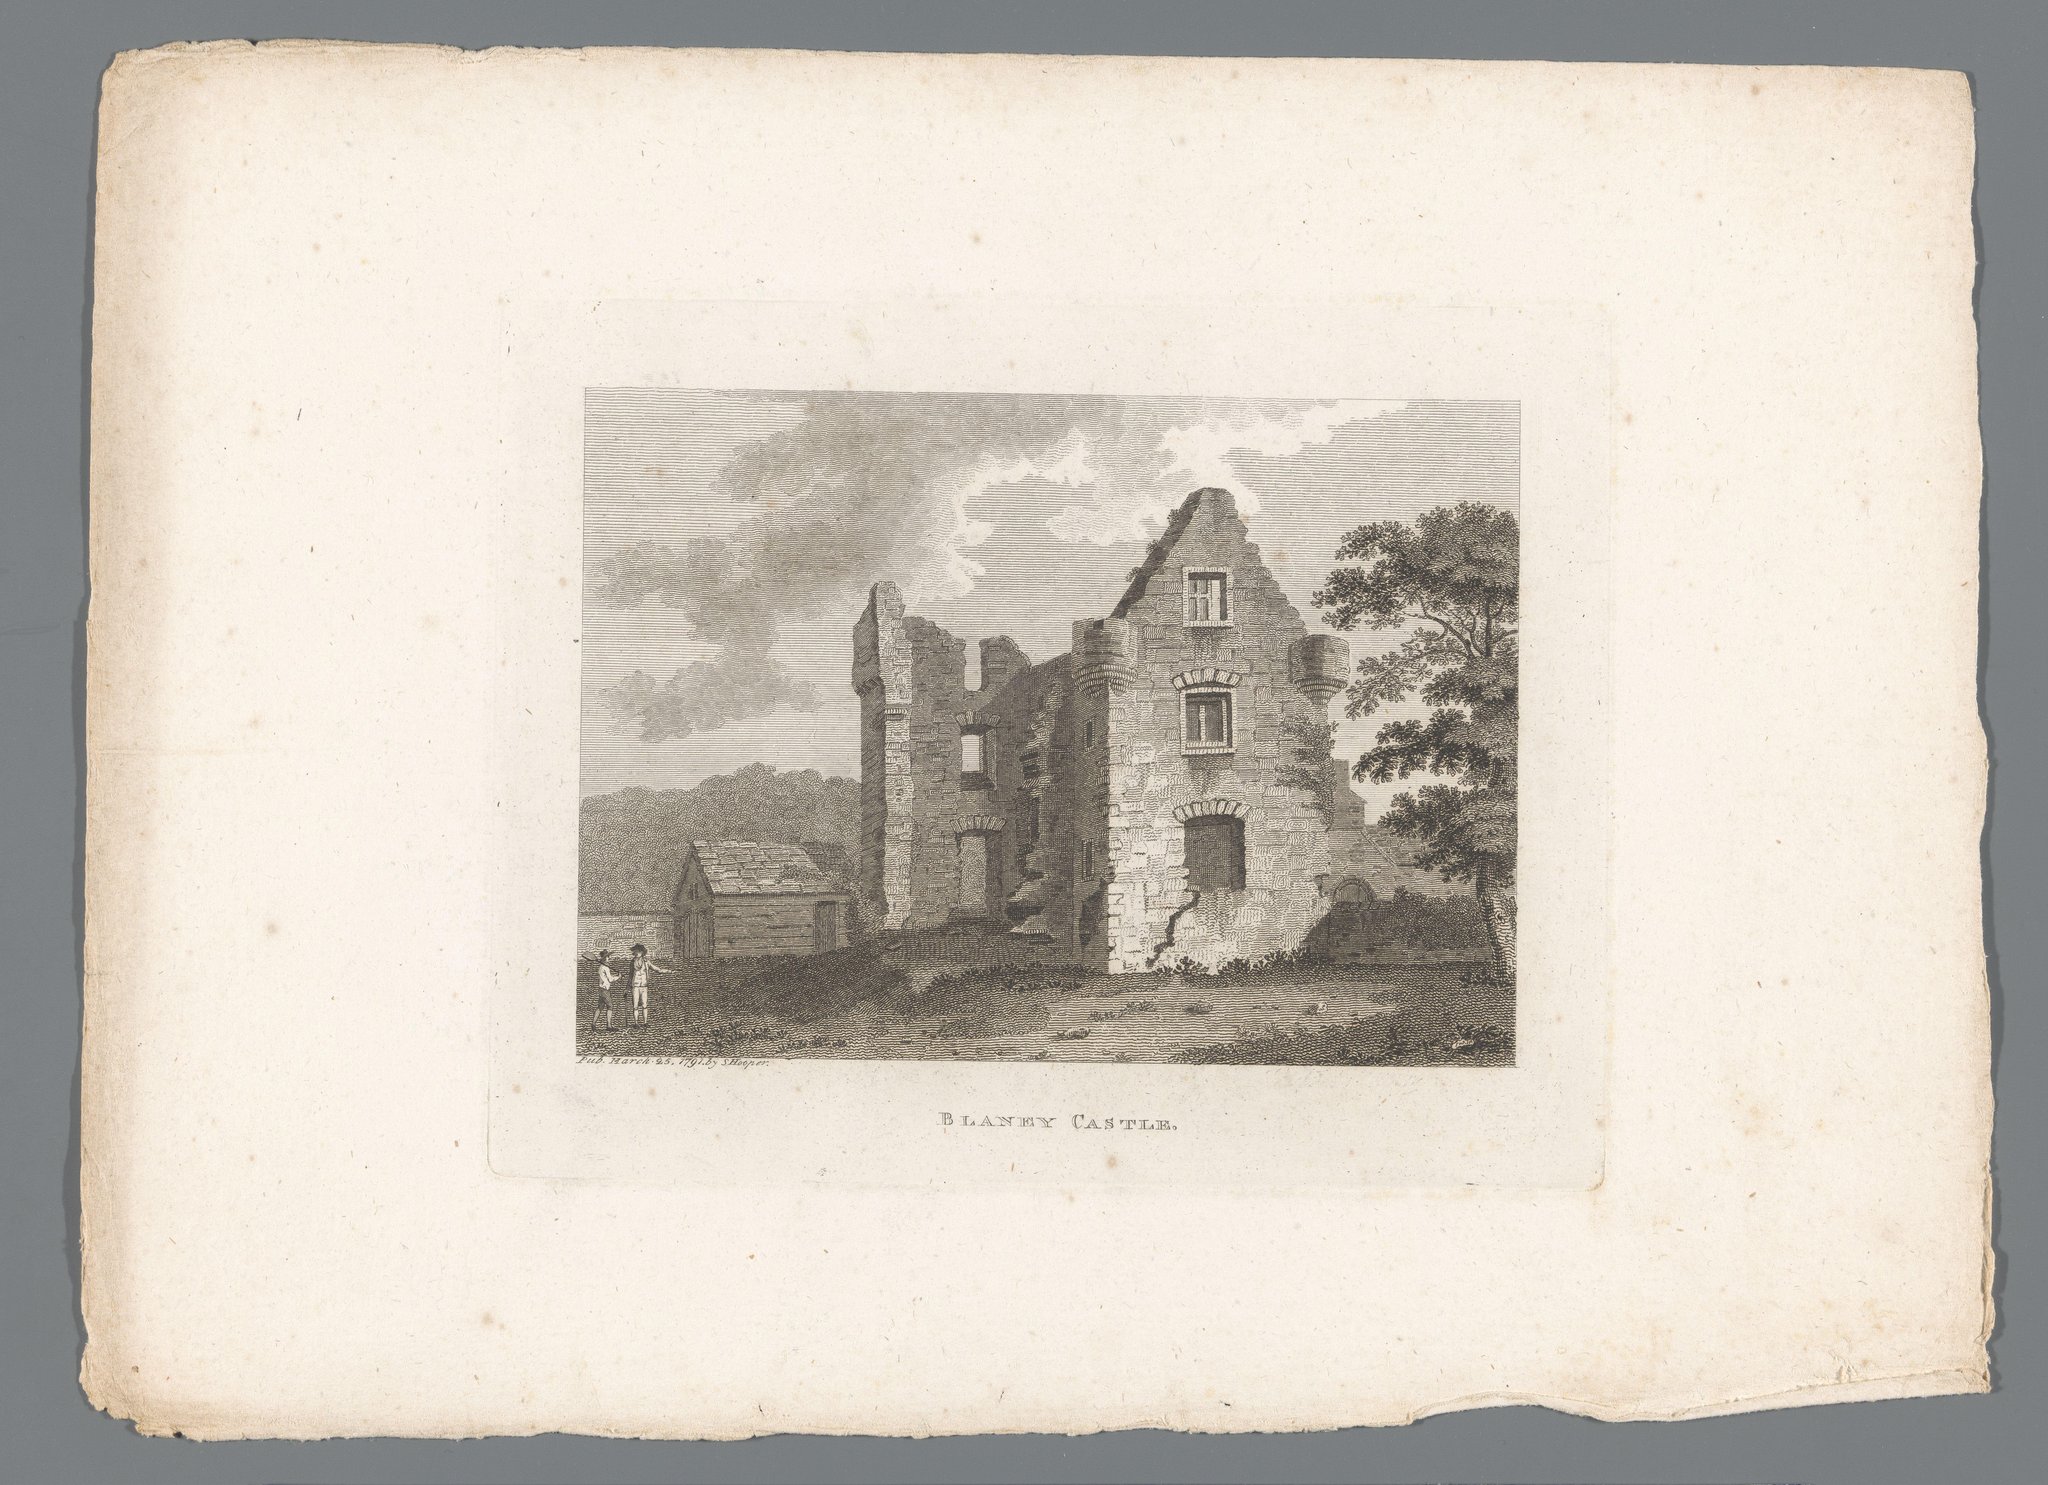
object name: book illustration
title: Blaney Castle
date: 1791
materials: paper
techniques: etching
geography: london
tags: landscape with ruins, landscape with tower or castle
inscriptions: date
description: Prent verschenen in: Grose, Francis. The antiquities of Ireland. Londen: S. Hooper, 1795, dl. 2.